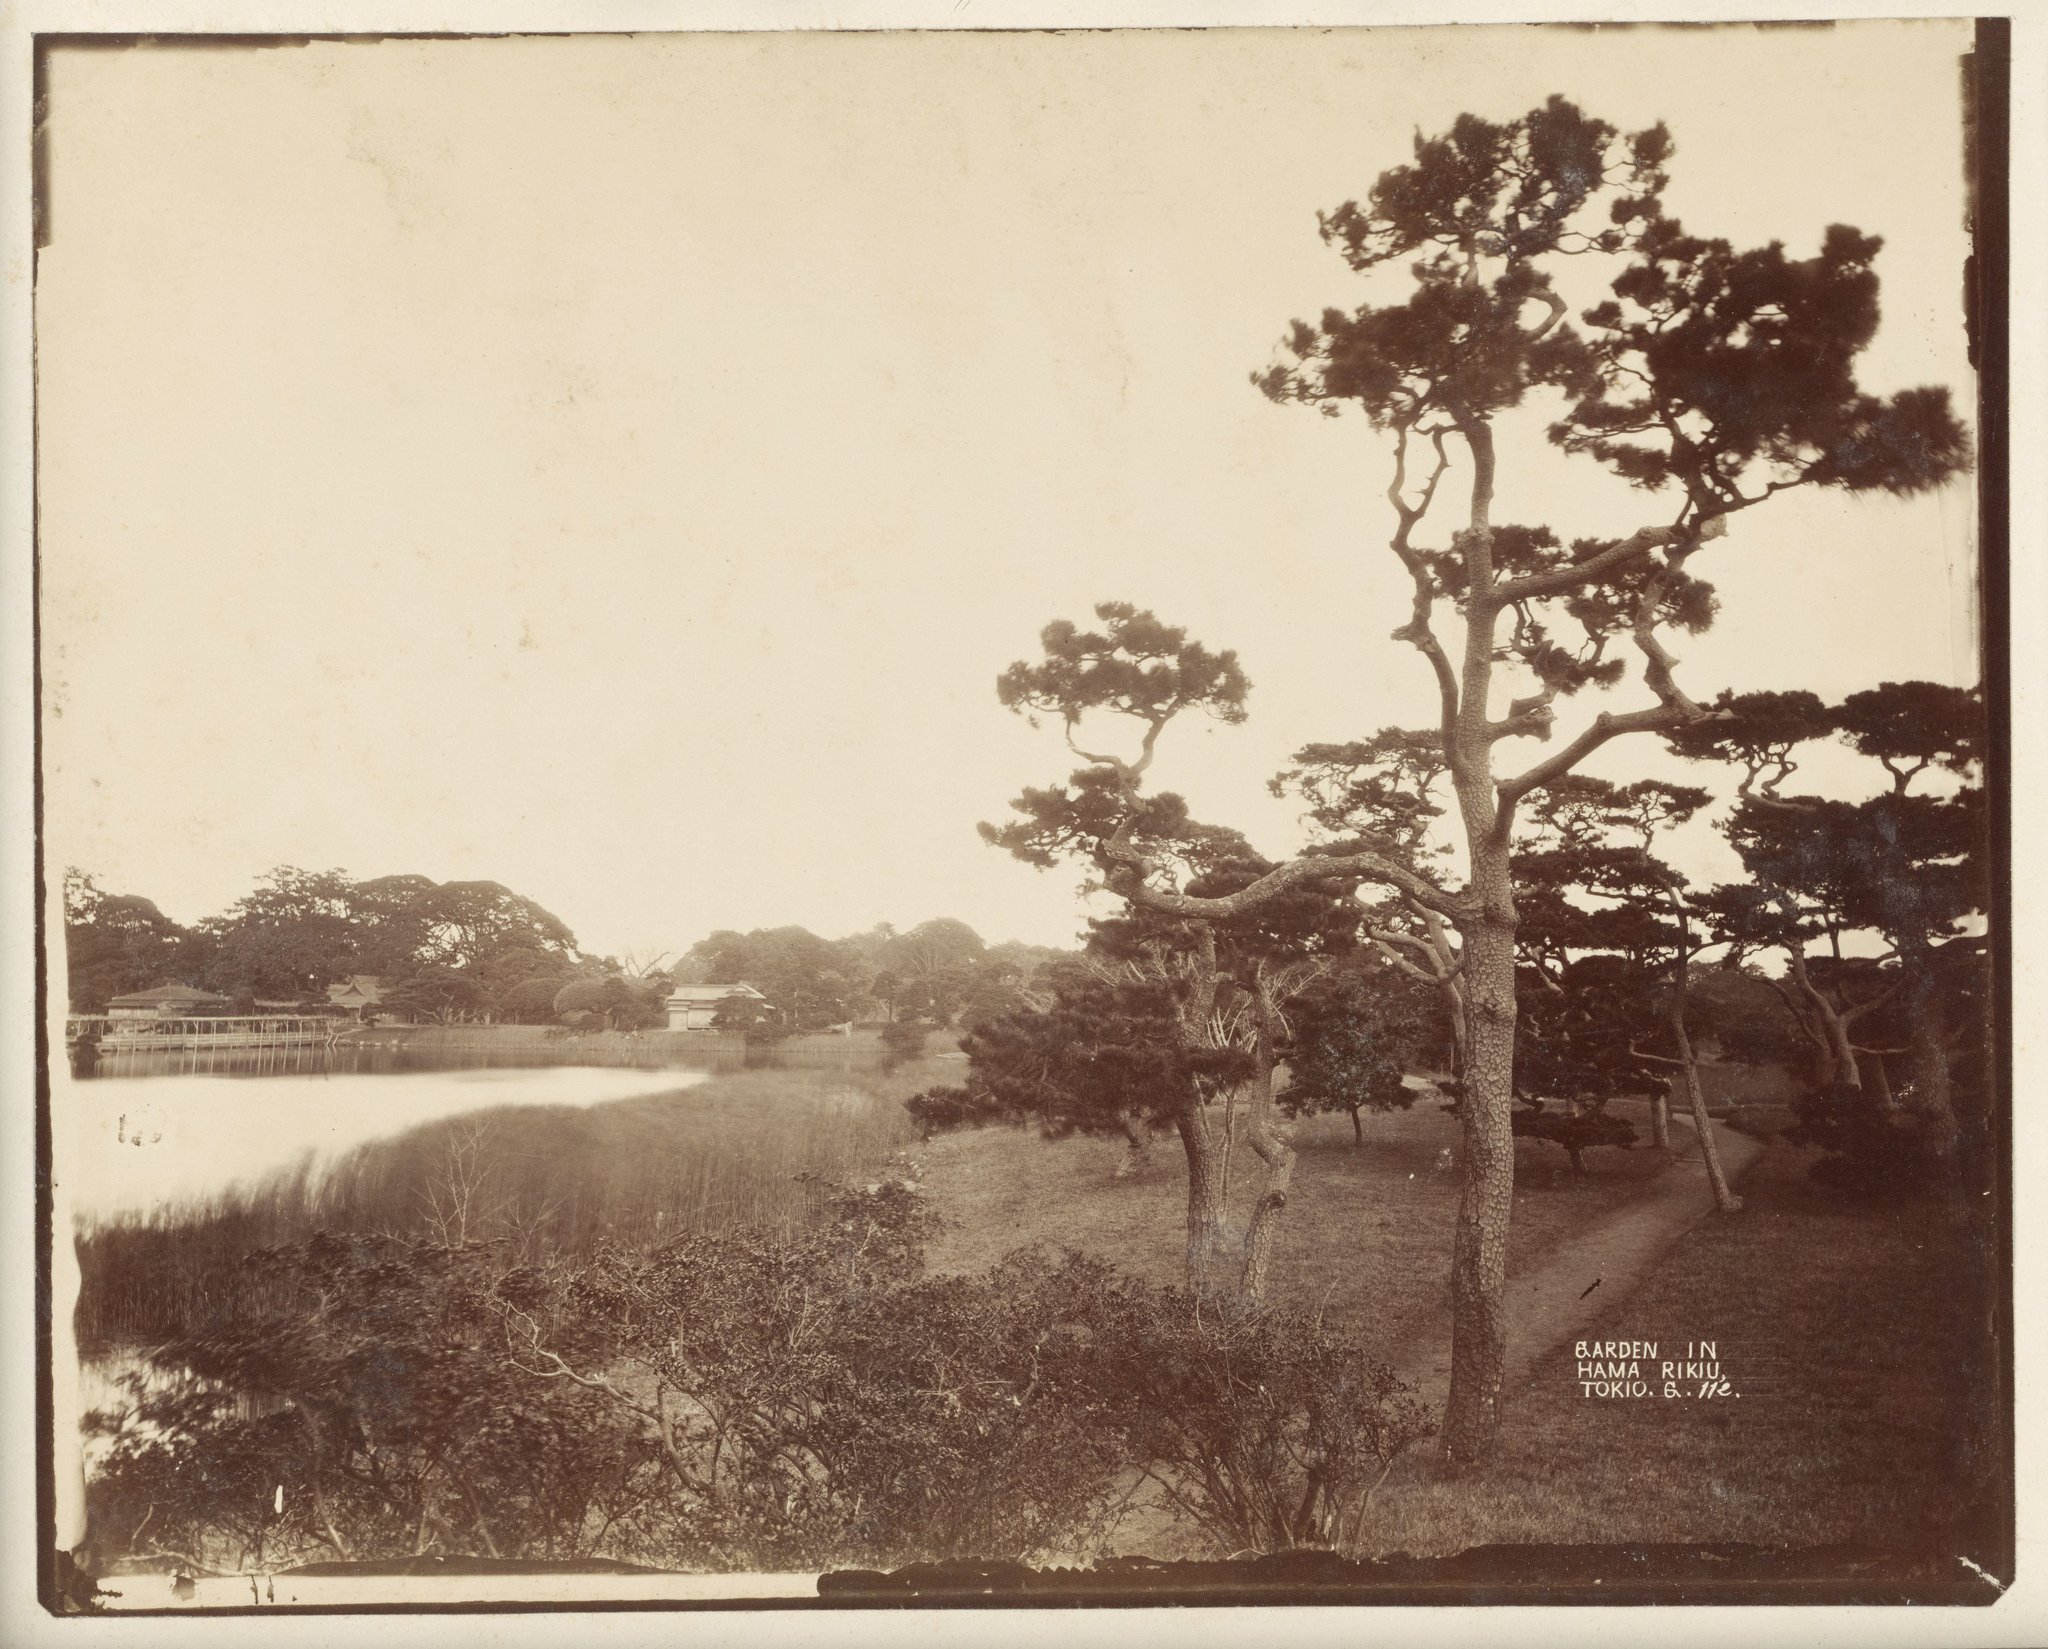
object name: photograph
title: Japan 1884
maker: Anonymous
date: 1884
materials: cardboard, paper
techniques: albumen print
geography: tokyo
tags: garden, hamarikyu gardens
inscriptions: number: ‘G. 112.’